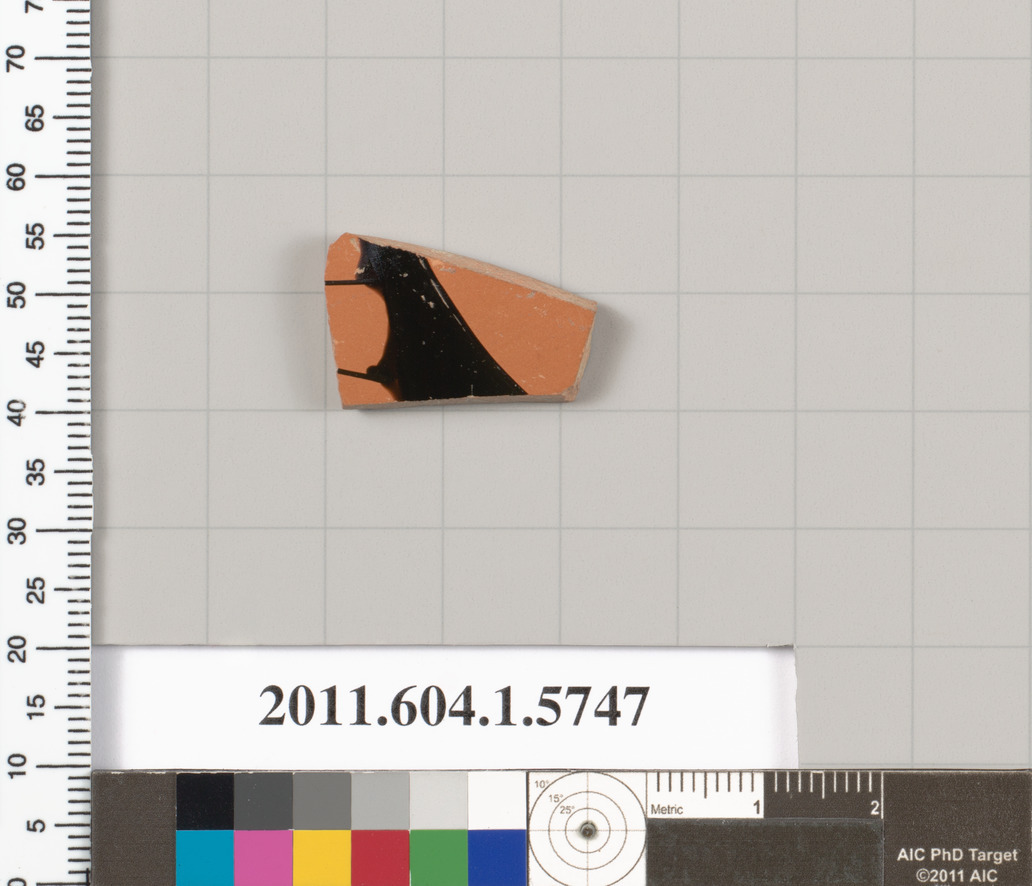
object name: kylix fragment, eye cup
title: Terracotta fragment of a kylix: eye-cup (drinking cup)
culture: greek, attic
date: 525-510 BCE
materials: terracotta